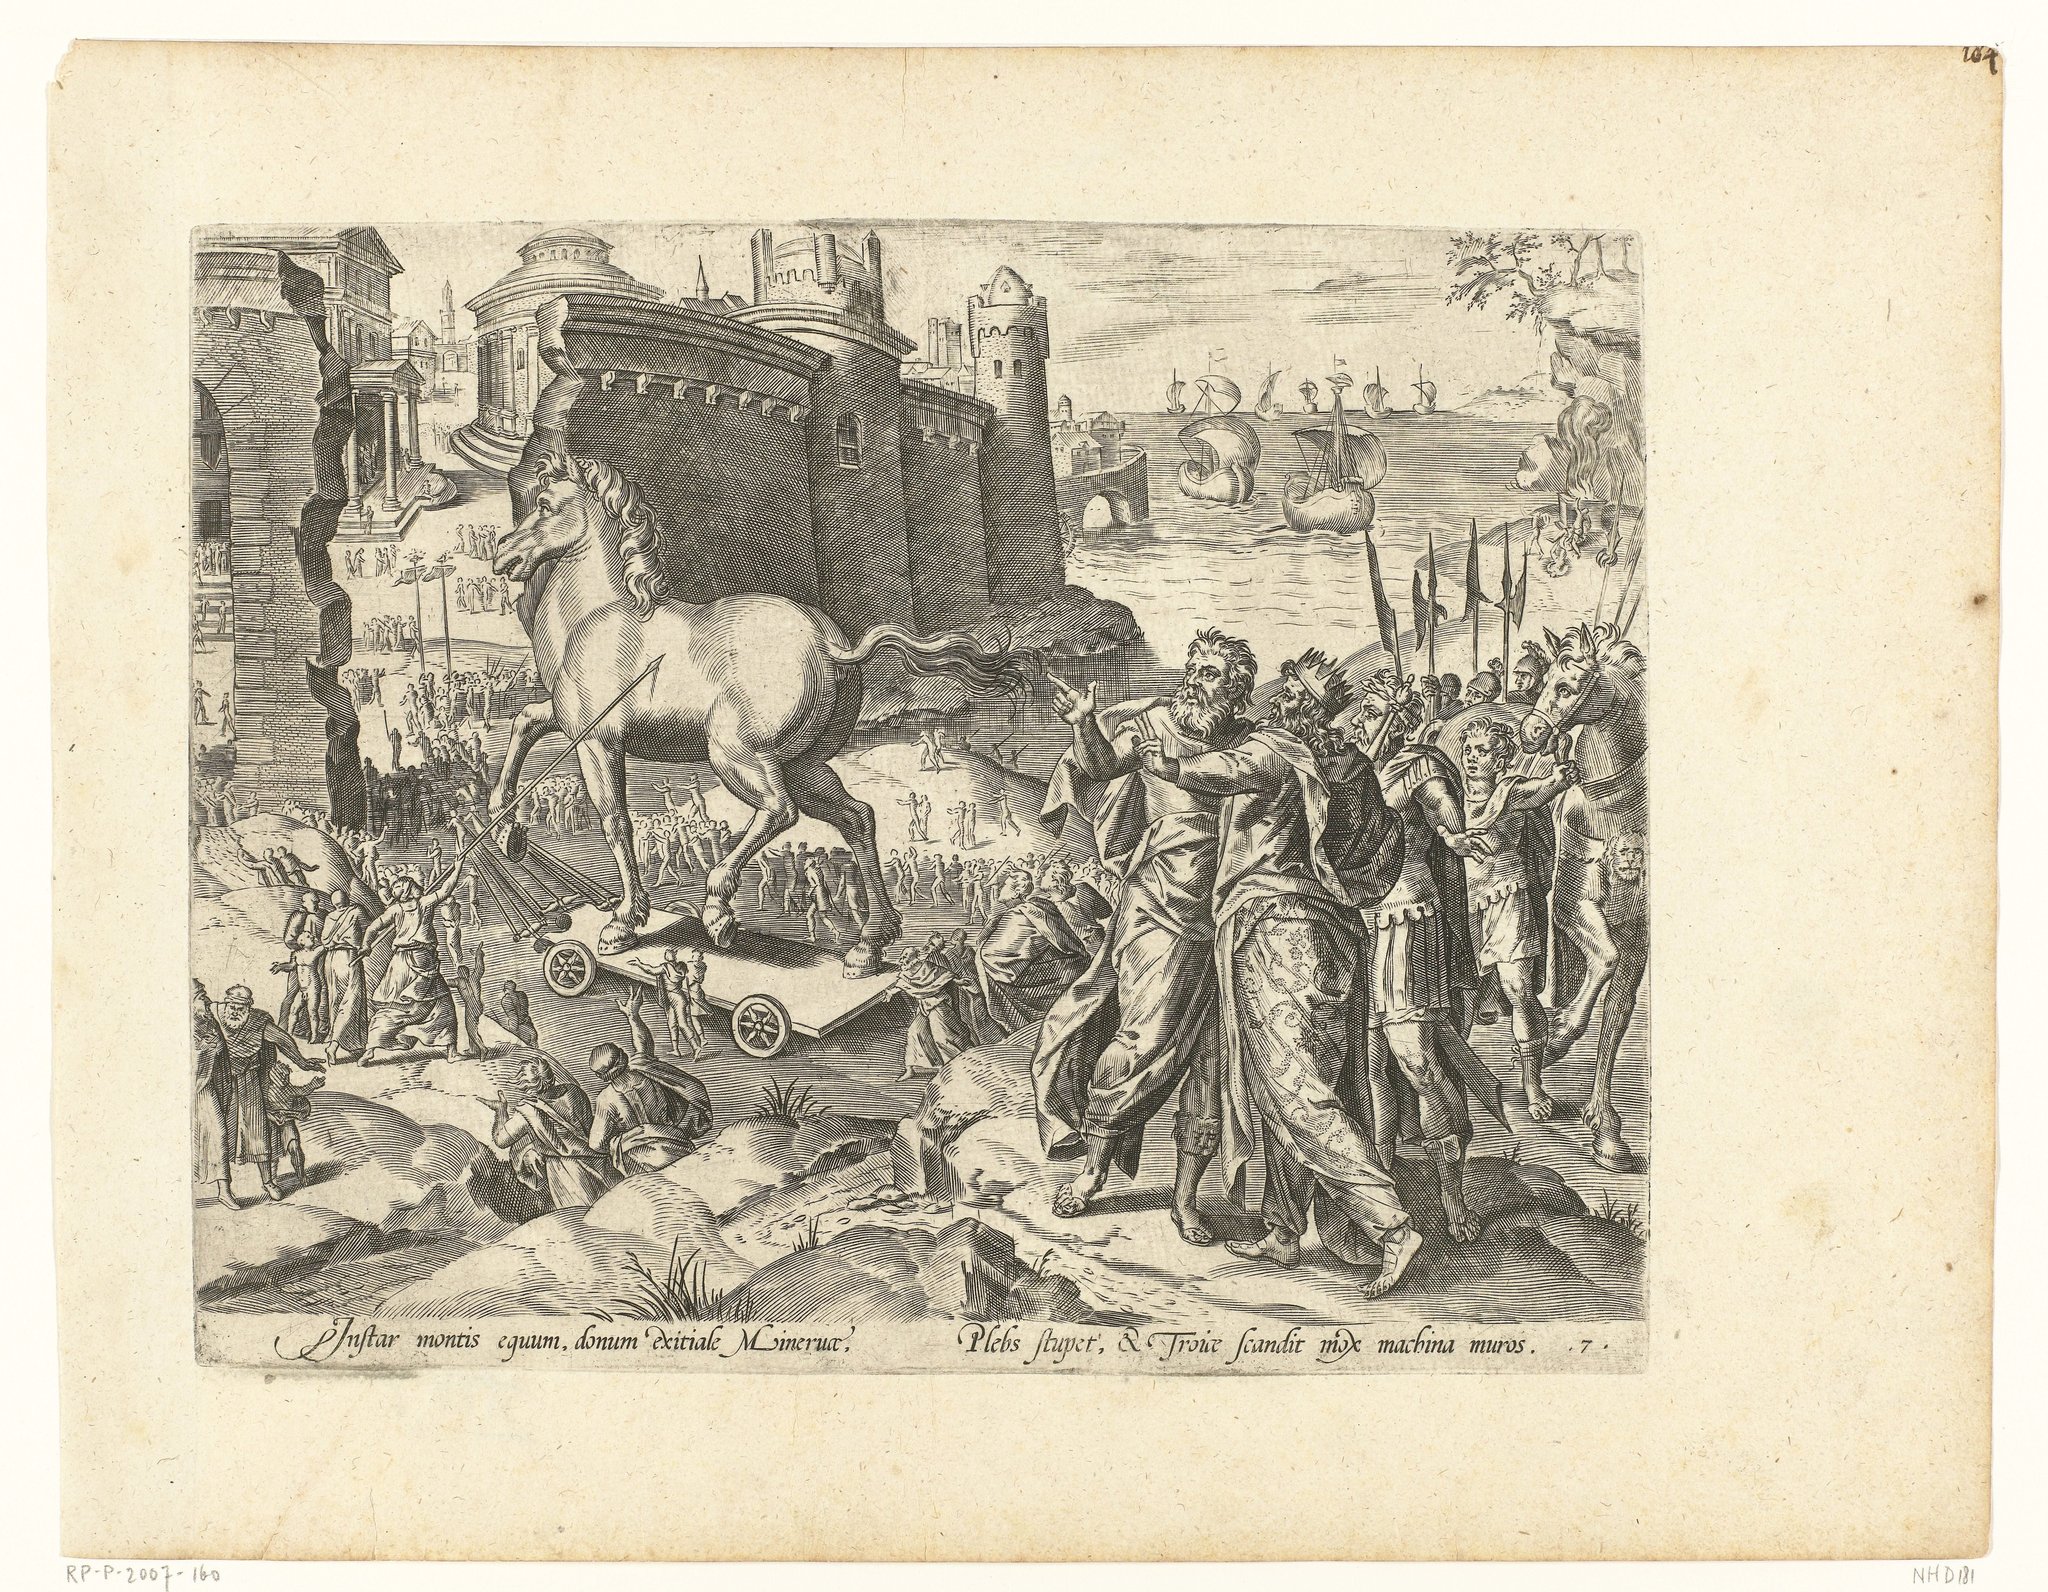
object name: print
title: De Trojaanse oorlog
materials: paper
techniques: engraving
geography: antwerp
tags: the wooden horse is brought into the city of troy, walls ~ fortified city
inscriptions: number: ‘184’, collector's mark: Lugt 2228, collector's mark: Lugt 2760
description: Het Trojaanse paard wordt door een opening in de stadsmuur naar binnen gereden en door een man met een lans in de zijflank gestoken. Rechts op de voorgrond staat koning Priamus met zijn gevolg, bij de stadsmuur staan inwoners van Troje. Onder de voorstelling staat een regel tekst in het Latijn, rechts genummerd: 7. De prent maakt deel uit van een serie prenten over de Trojaanse oorlog.